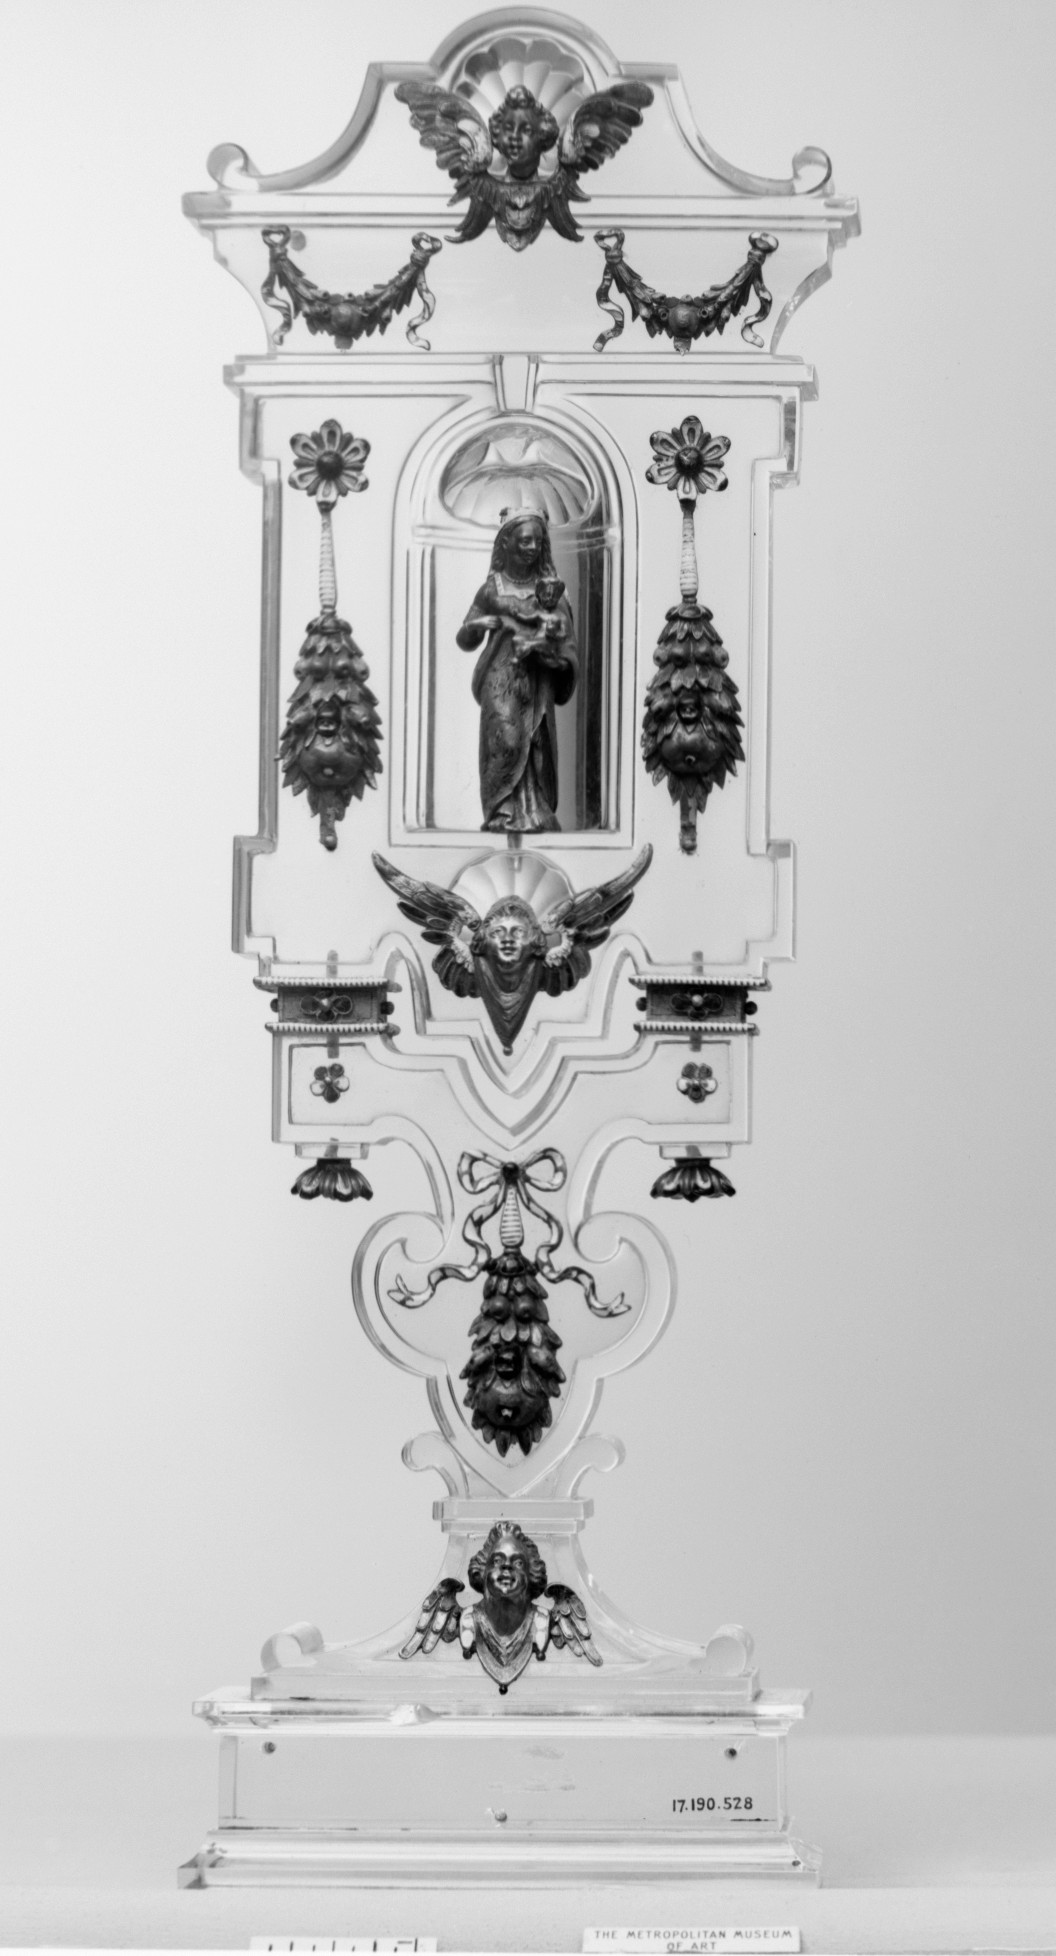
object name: shrine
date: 1601-1633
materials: crystal, enamel, gold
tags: virgin mary